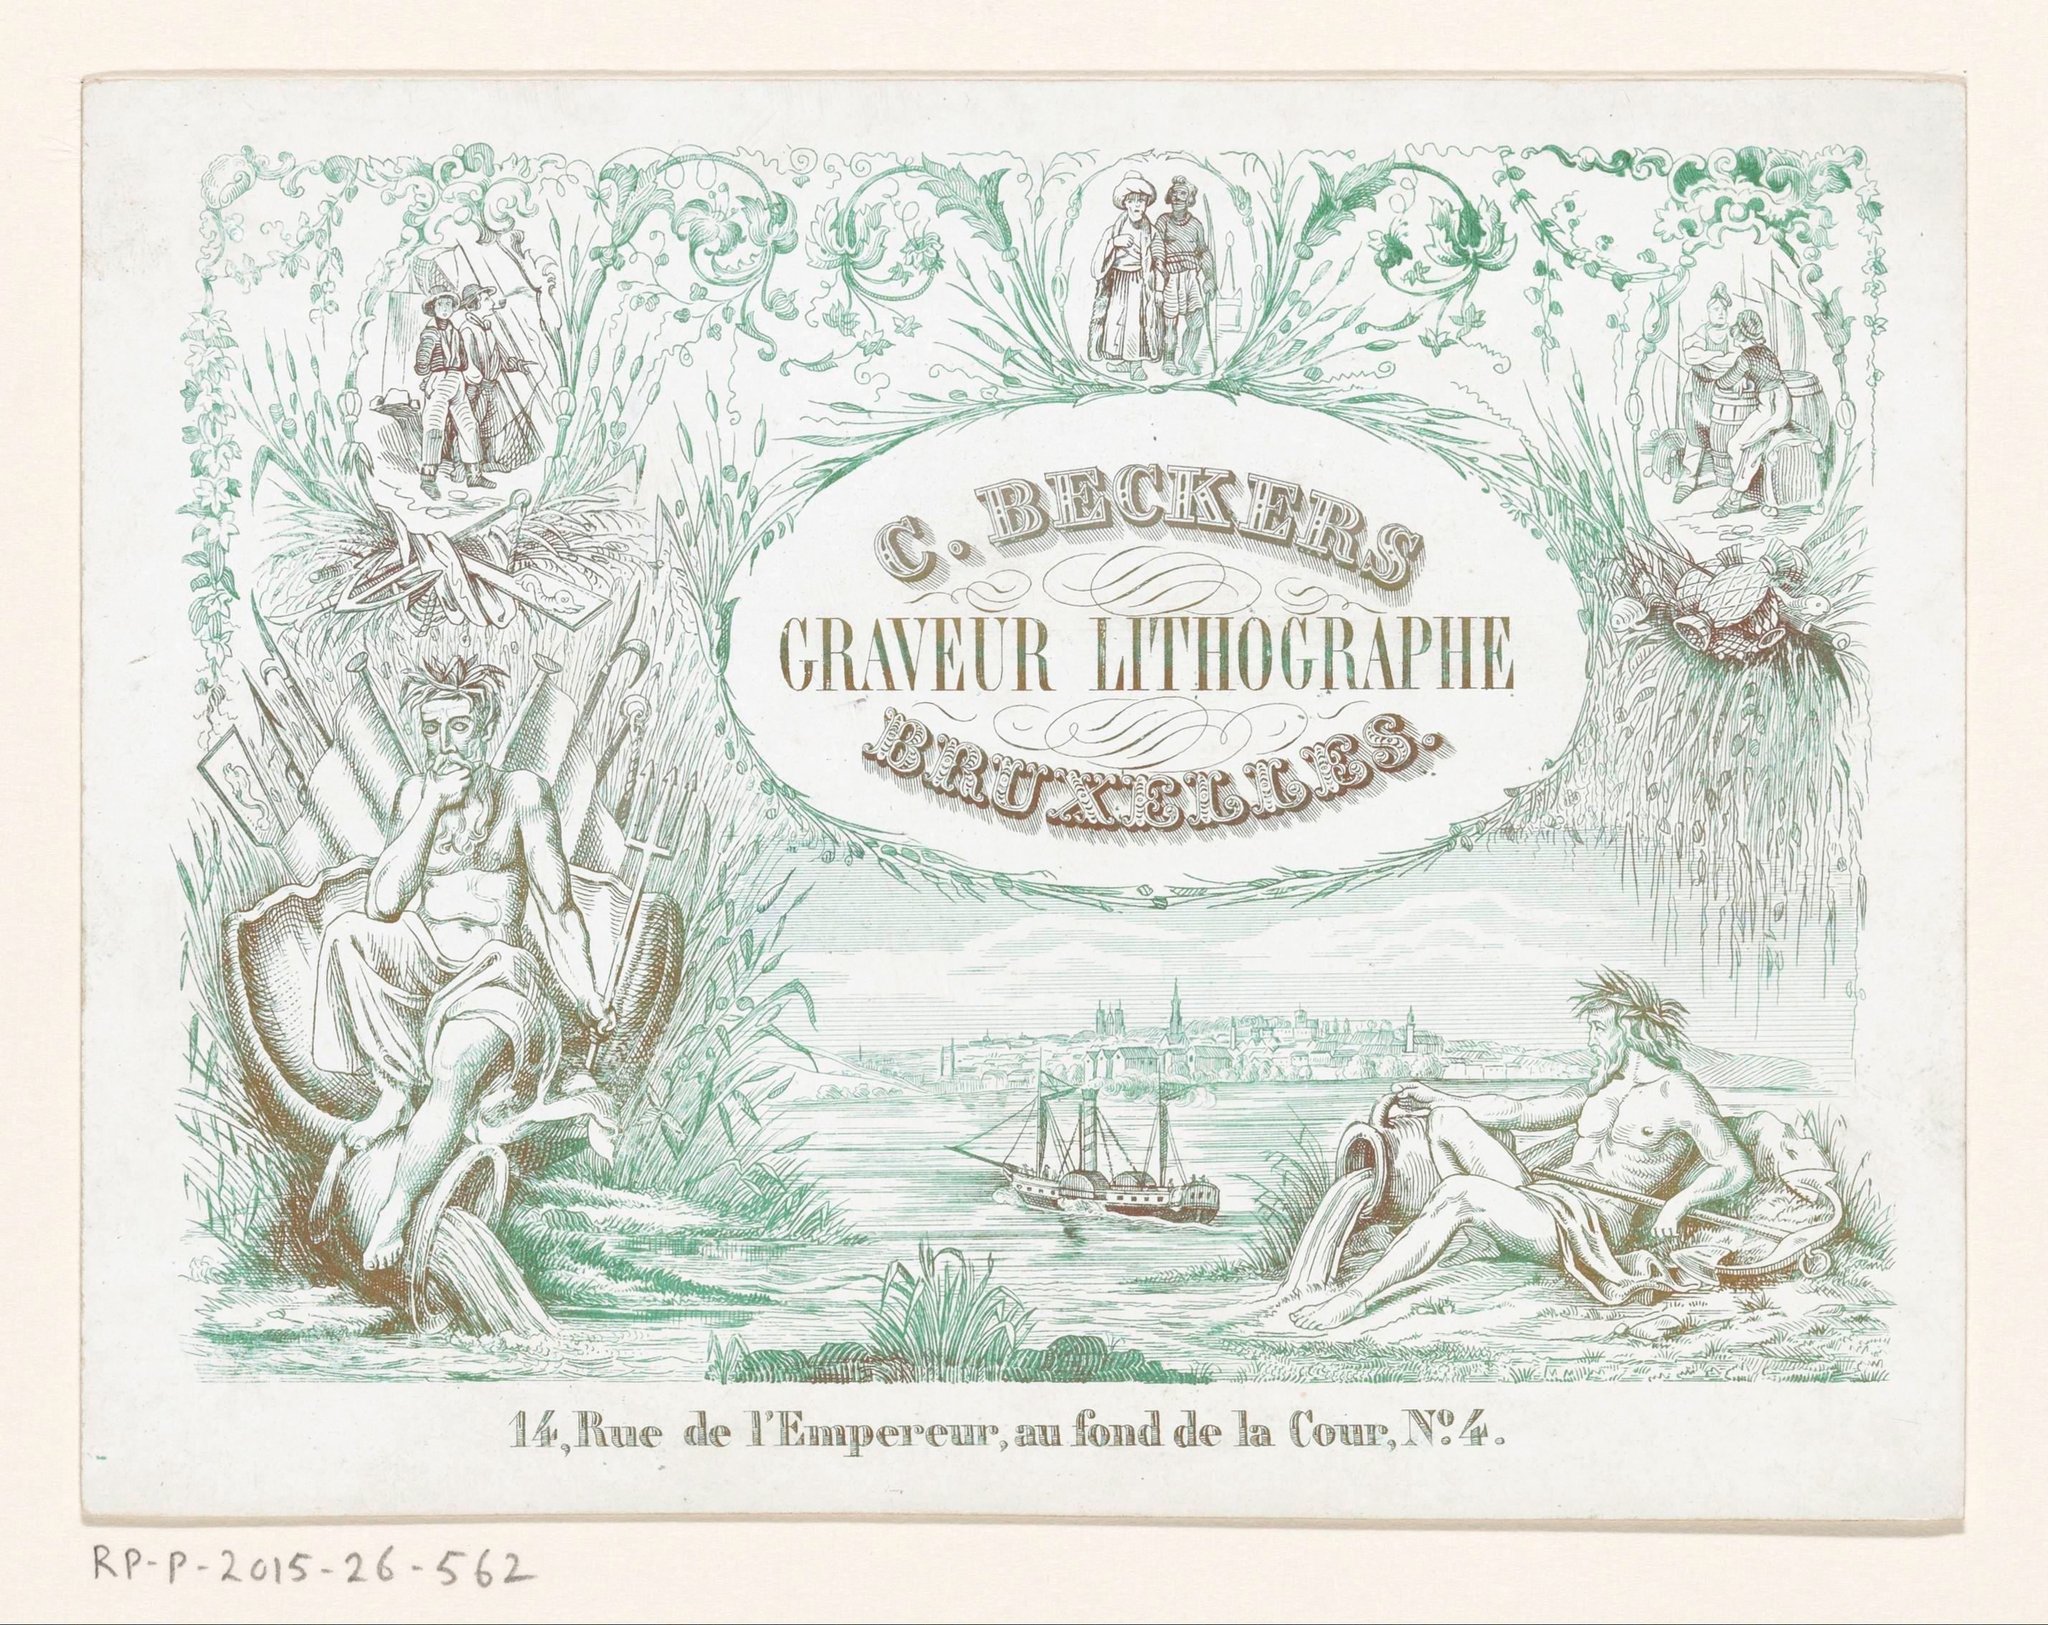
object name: visiting card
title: Visitekaartje van lithograaf C. Beckers te Brussel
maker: c. beckers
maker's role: print maker, printer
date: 1845-1862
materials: porcelainized cardboard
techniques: lithograph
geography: brussels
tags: river-gods, specific aspects, allegorical aspects of neptune; neptune as patron, steamship, motorship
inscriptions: collector's mark: Lugt 2228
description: Riviergezicht met een stoomraderboot en een plaats aan de oever van de rivier. Rechts op de voorgrond de personificatie van de rivier, links Neptunus gezeten op een schelp met harpoenen en vaandels. Aan de bovenzijde bloemmotieven met drie scènes met elk twee figuren, waaronder vissers.